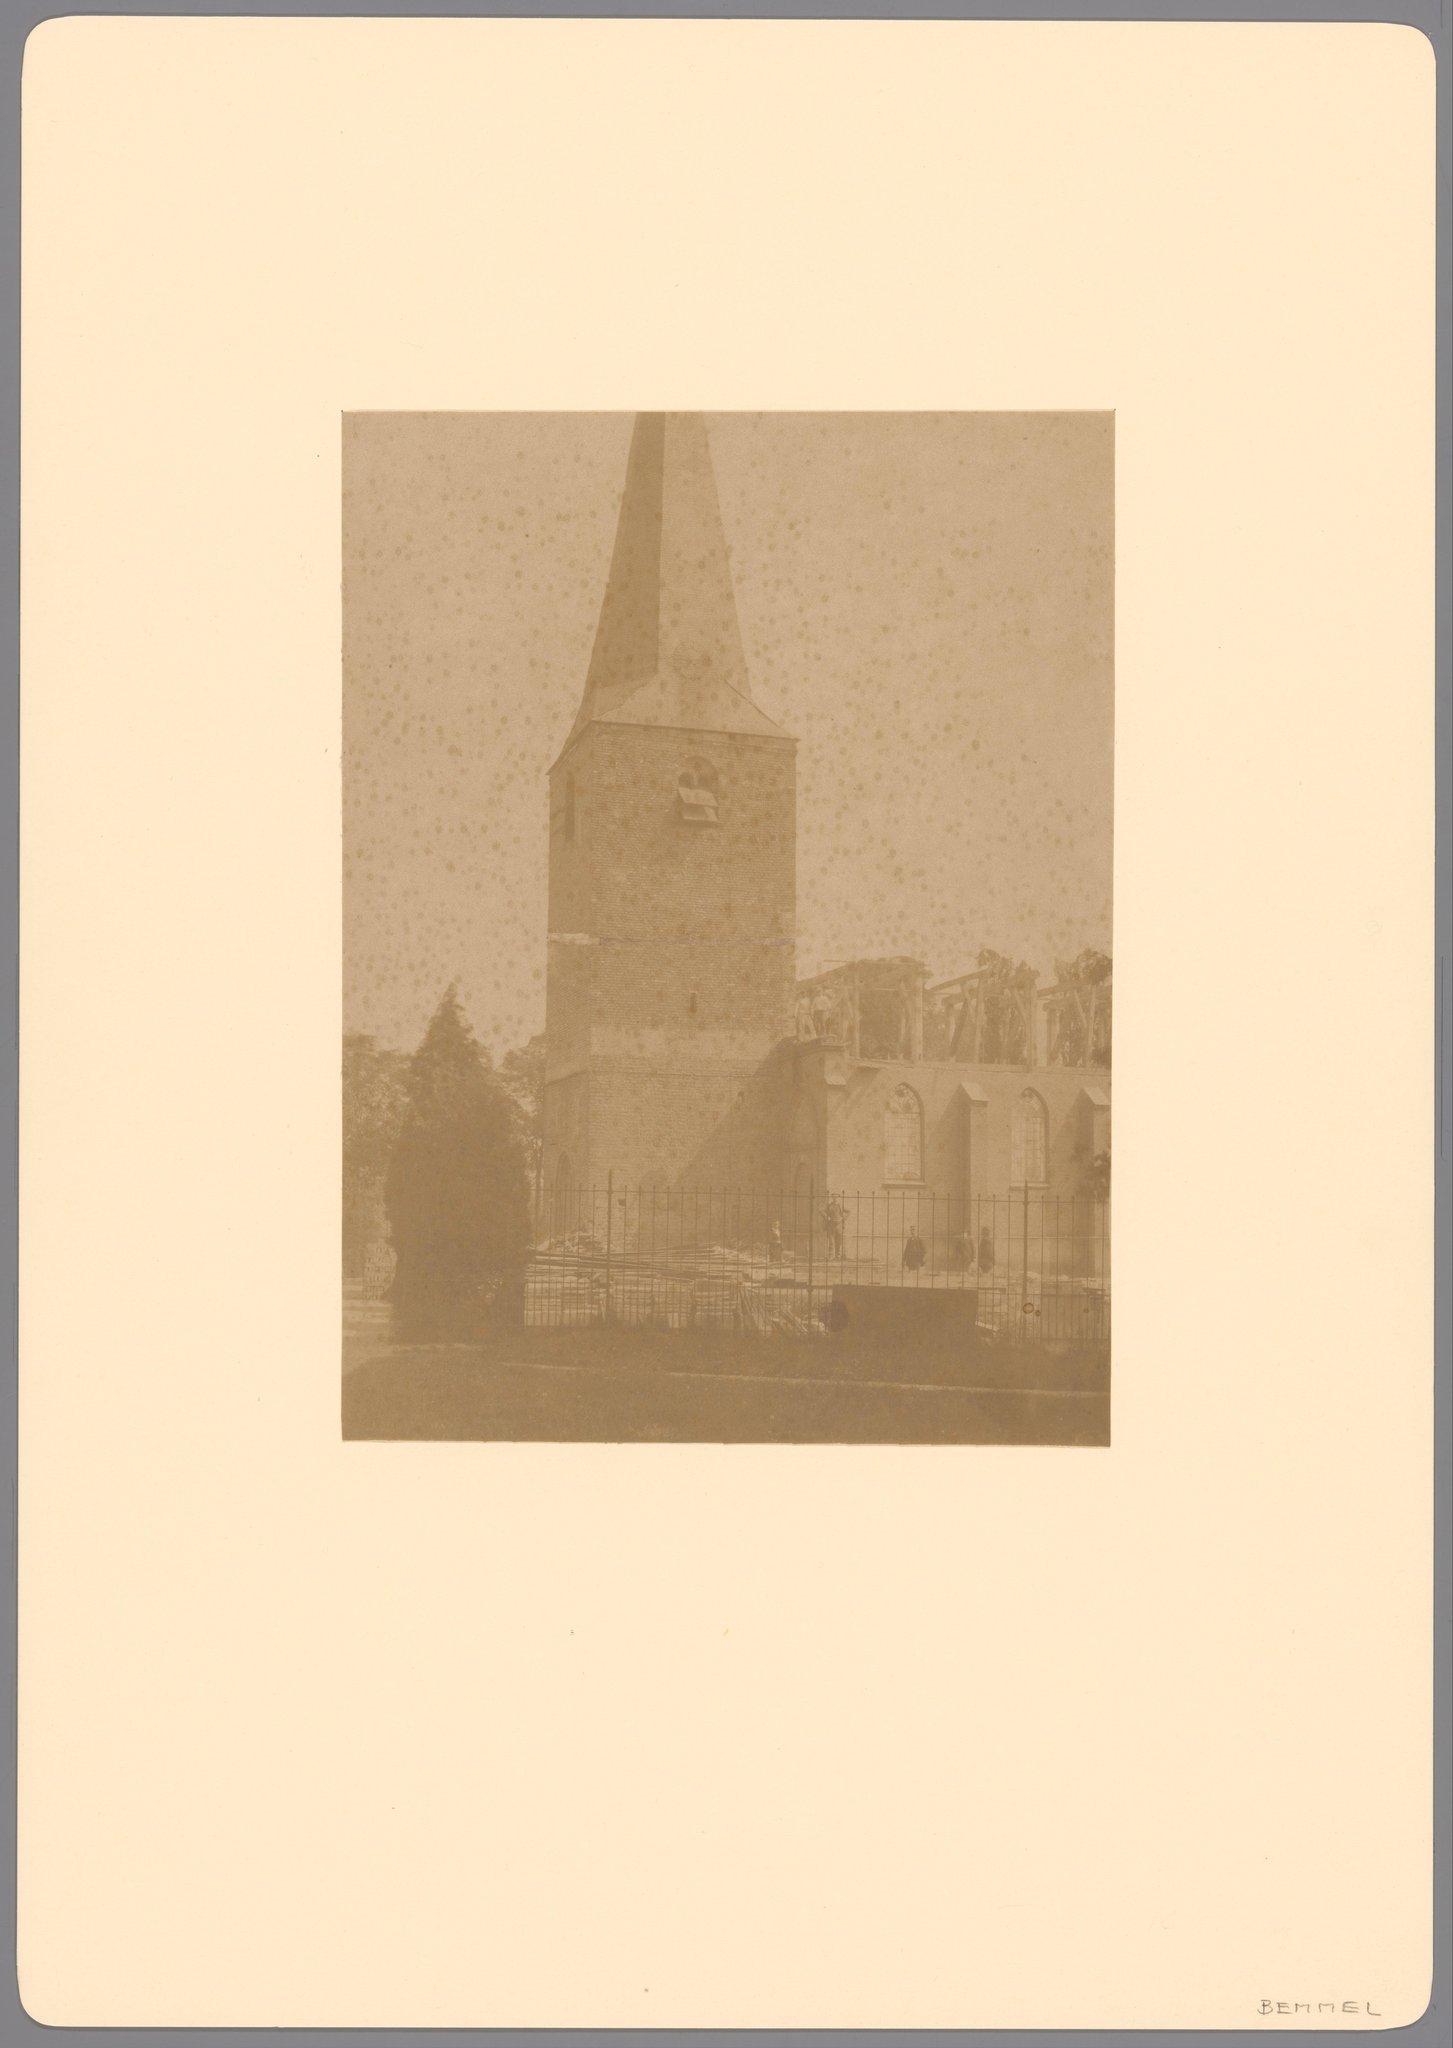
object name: photograph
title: Gezicht op de Hervormde Kerk te Bemmel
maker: anoniem (monumentenzorg)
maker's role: fotograaf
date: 1890-1920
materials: cardboard, photographic support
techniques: albumen print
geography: bemmel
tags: church (exterior)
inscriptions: annotation: ‘Bemmel (G.)/ Toren a/d N.H. Kerk’, annotation: ‘Bemmel’